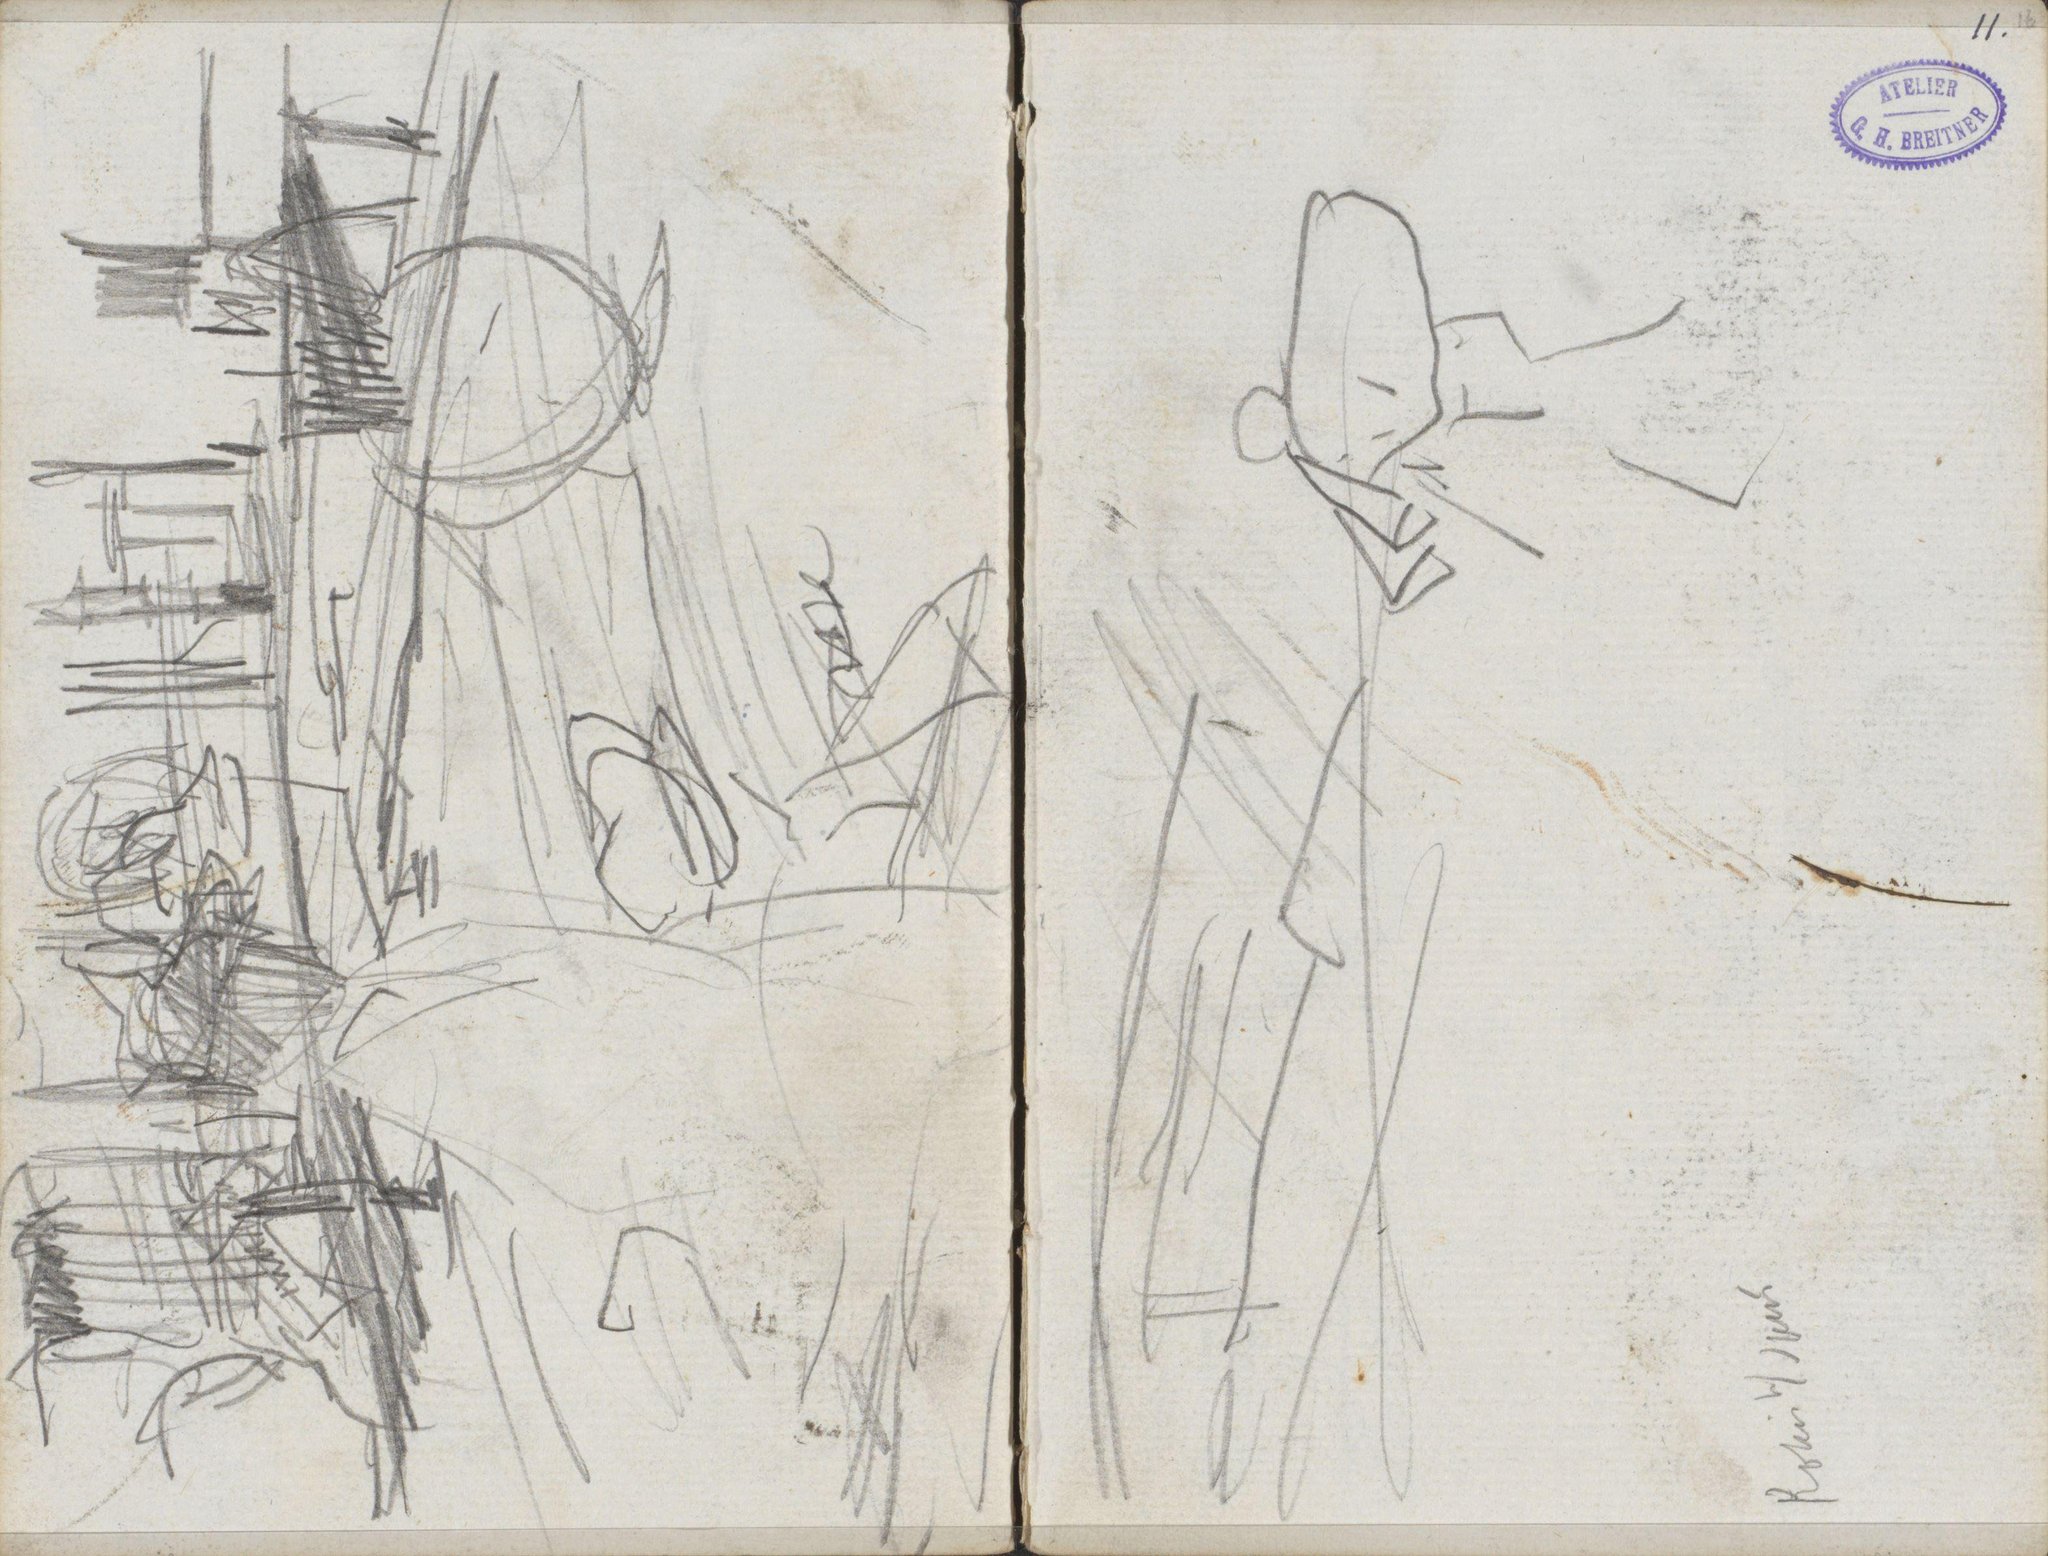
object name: sketchbook leaf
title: Gezicht op het Rokin te Amsterdam, ter hoogte van het Spui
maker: george hendrik breitner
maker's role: draughtsman, painter, print maker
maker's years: 1857-1923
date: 1891-1894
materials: paper, pencil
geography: amsterdam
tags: canals, waters (in city), civic architecture; edifices; dwellings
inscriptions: :, annotation: ‘Rokin h/ Spui’, workshop stamp: Lugt 291d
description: Pagina 15 en pagina 16 uit een schetsboek met 15 bladen.